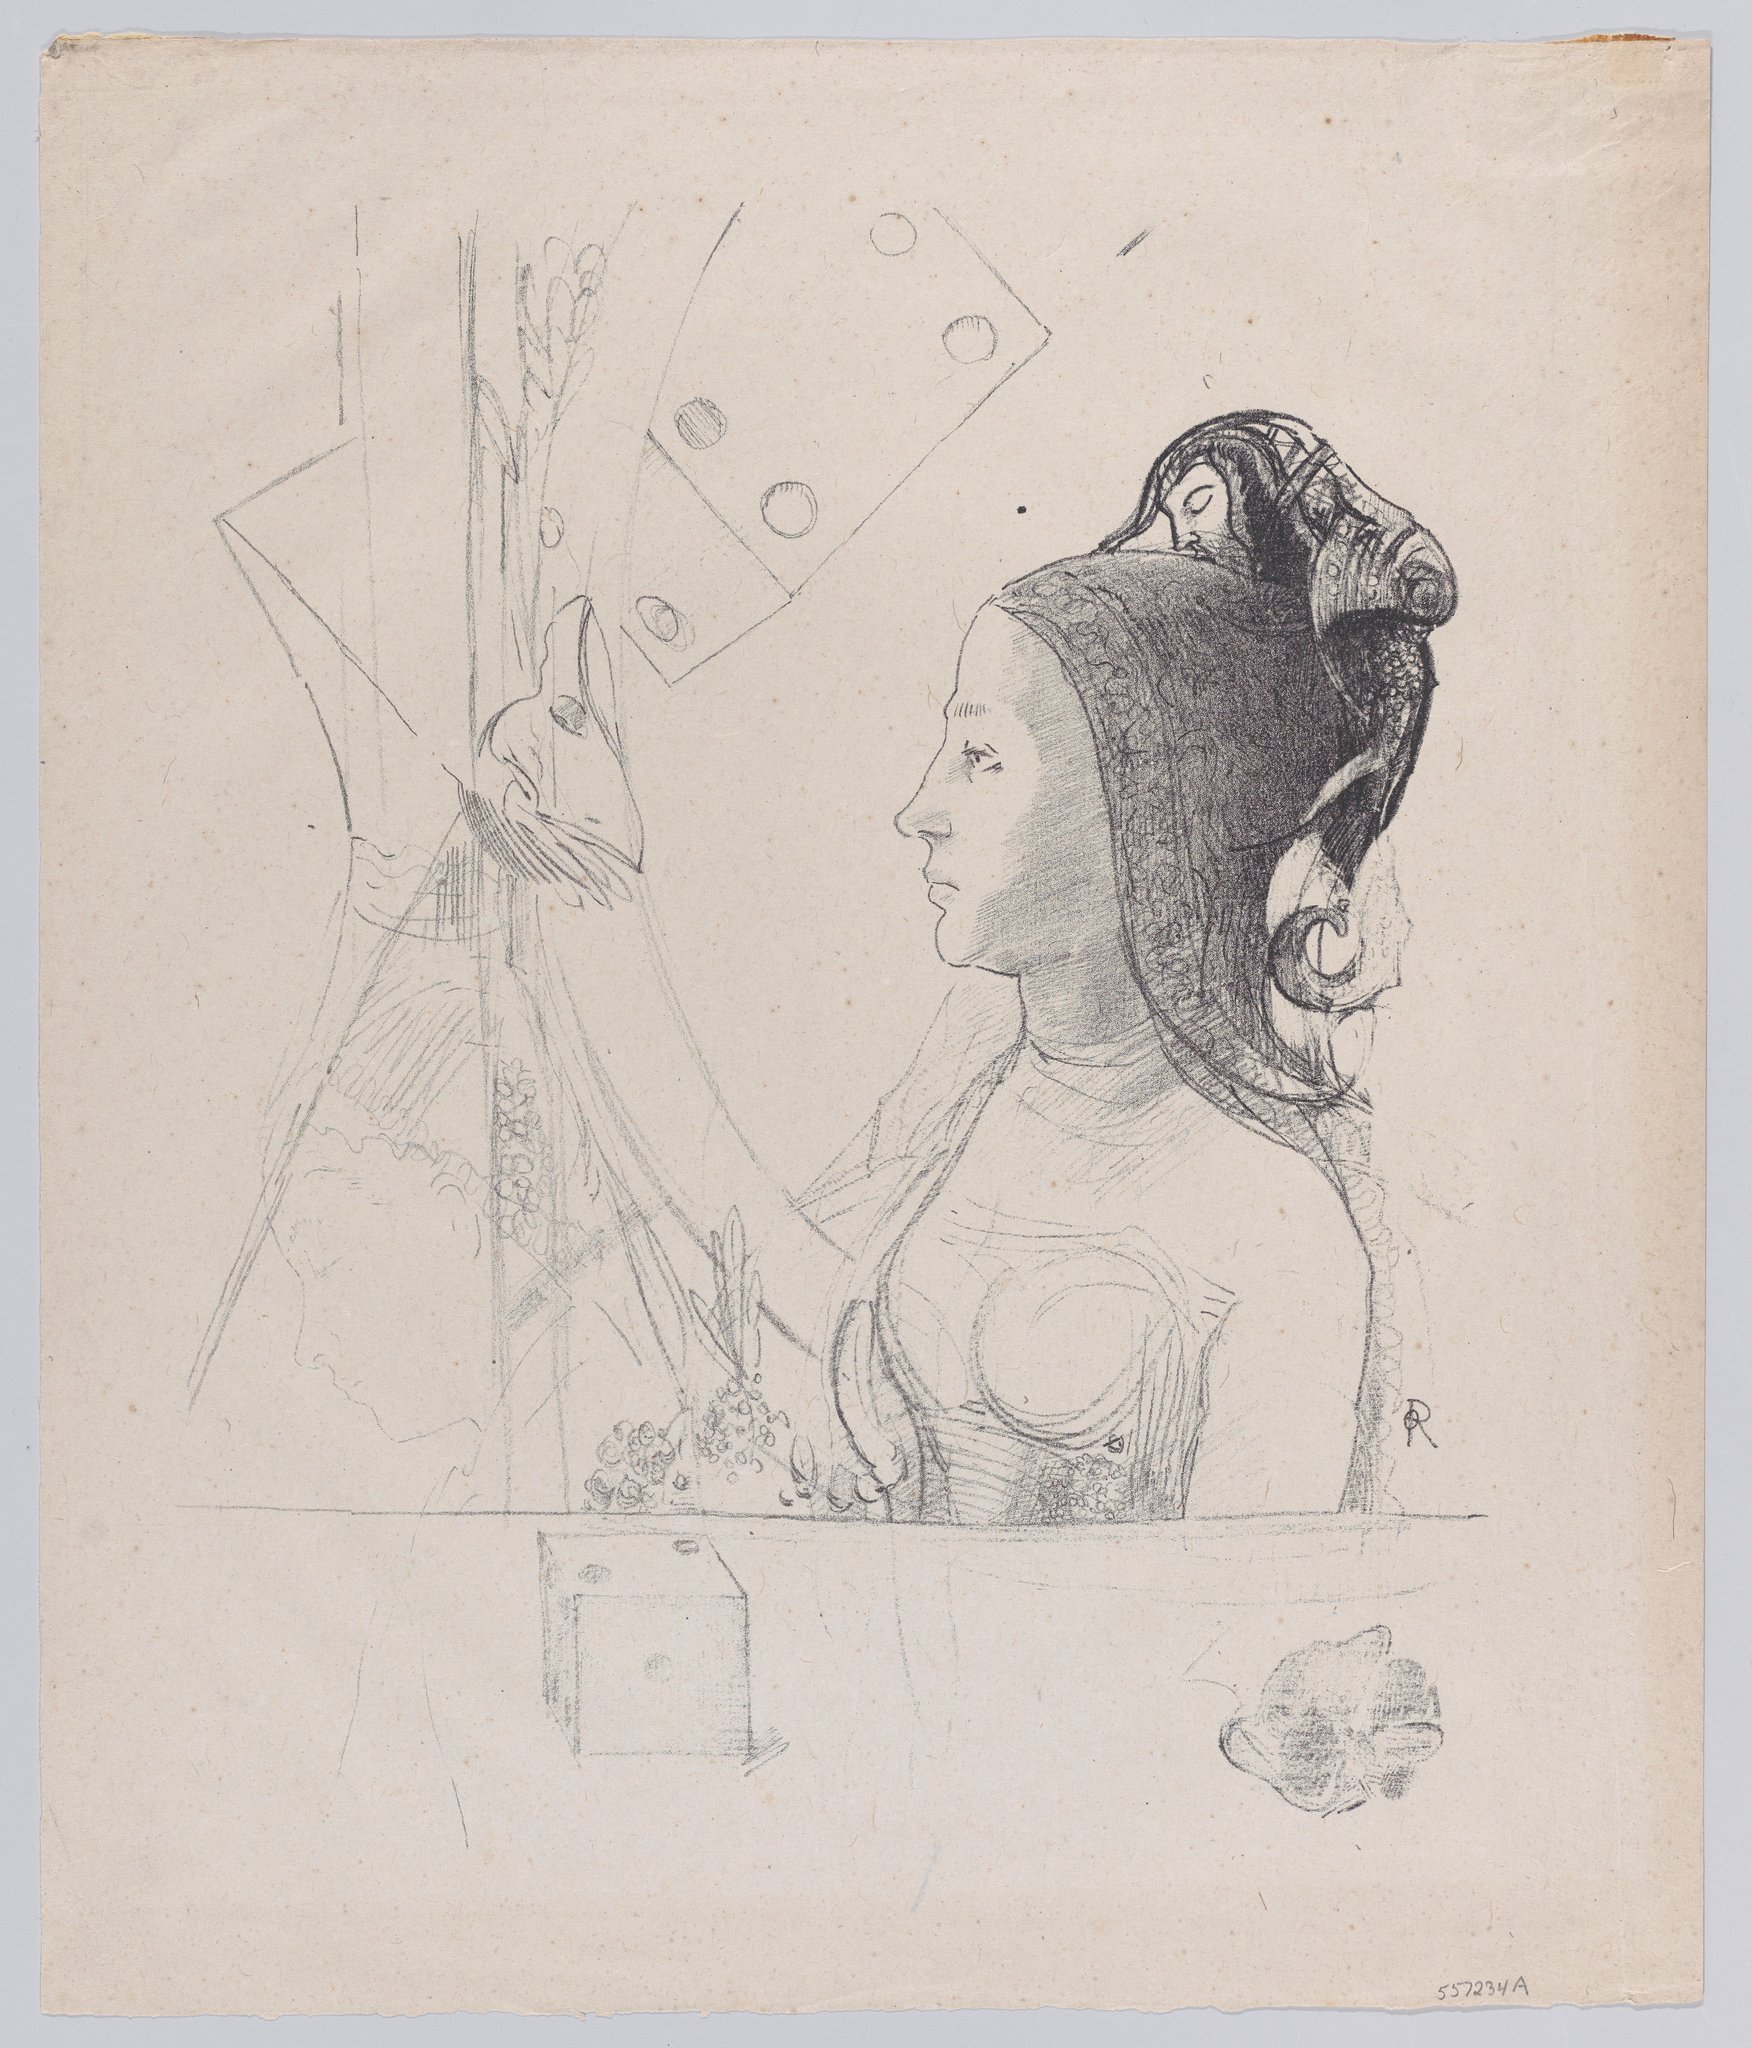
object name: print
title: A Trial Plate for Mallarmé's "Un coup de dés" (A Throw of the Dice)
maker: odilon redon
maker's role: artist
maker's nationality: french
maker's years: 1840-1916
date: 1897-1898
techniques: lithograph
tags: women,dice